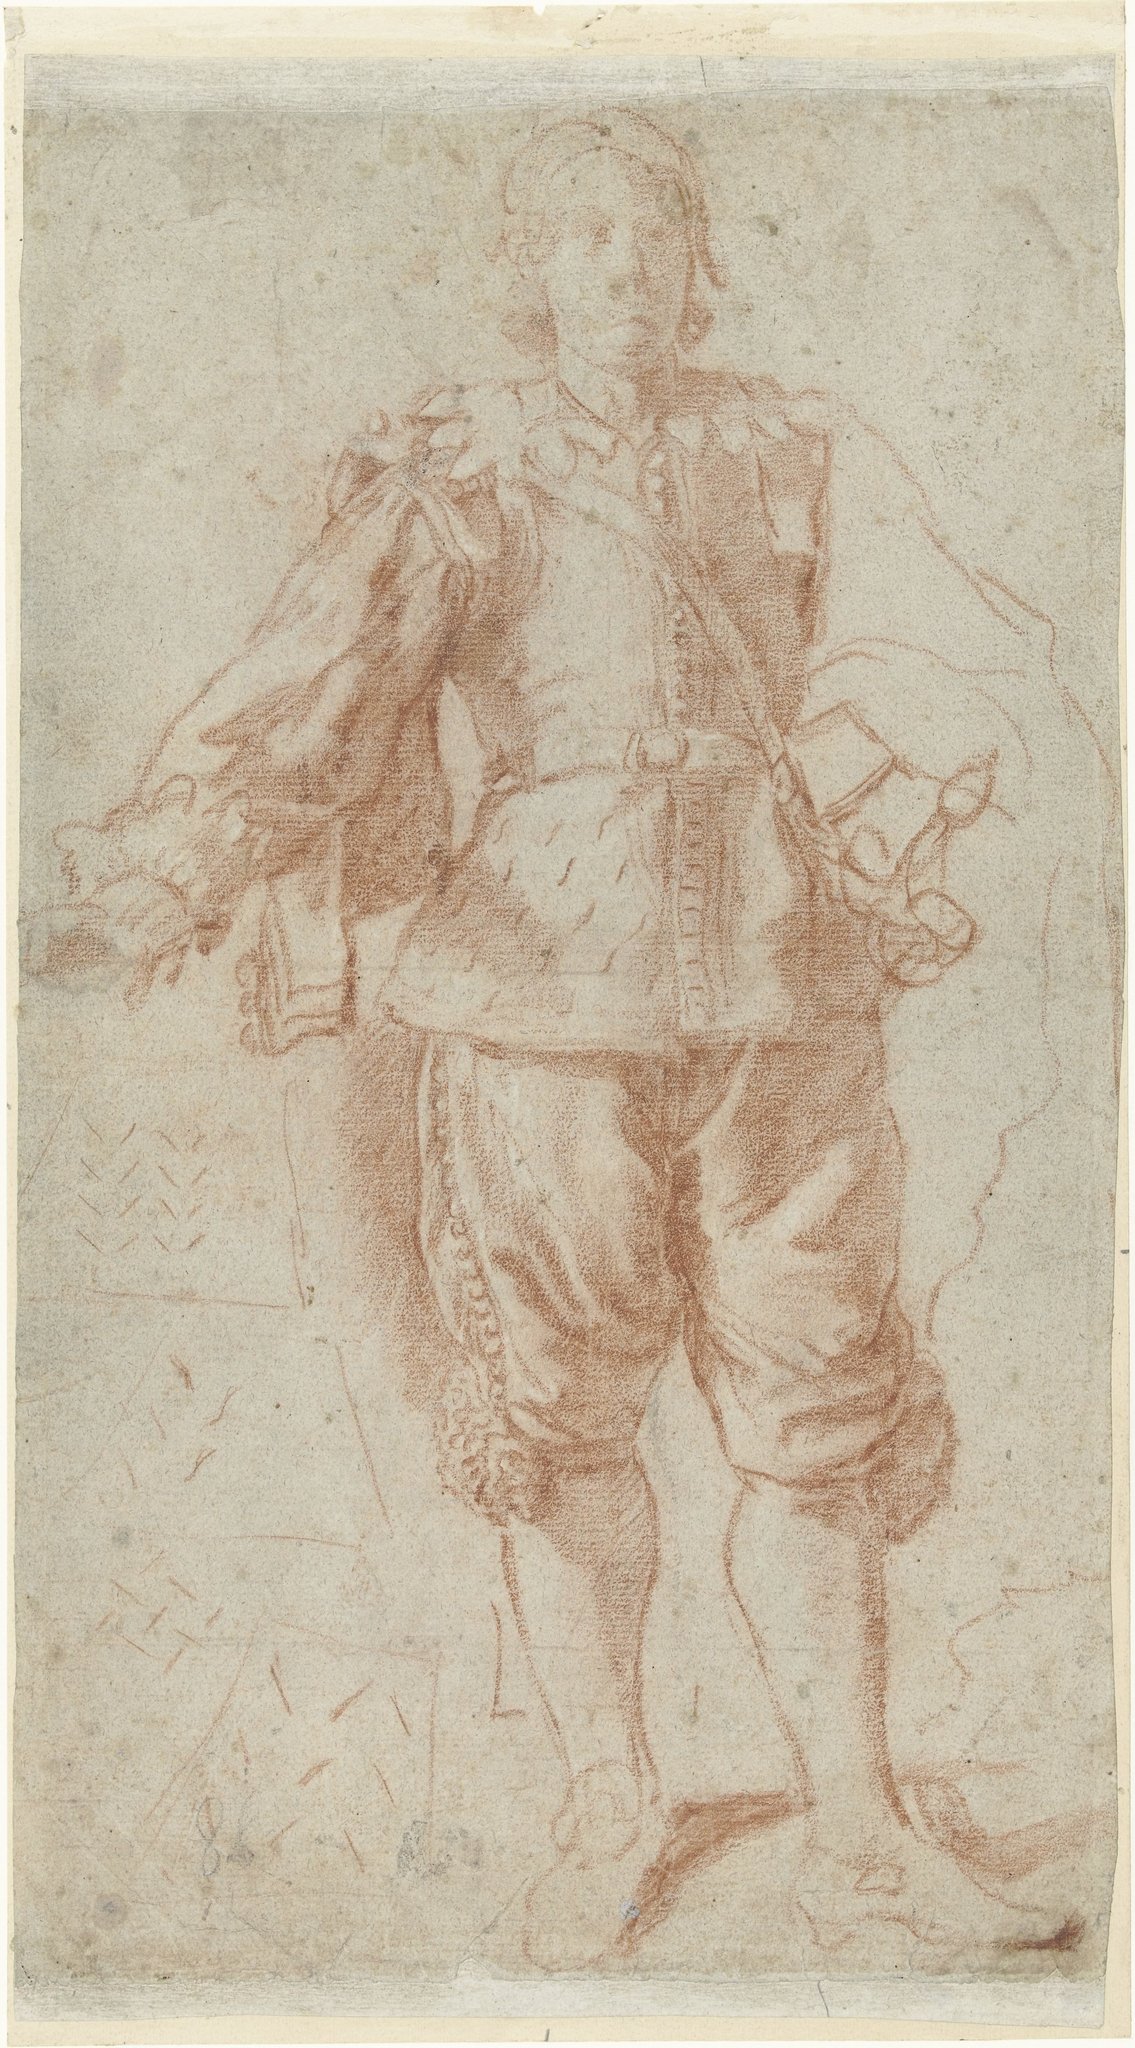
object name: drawing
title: Studie voor een portret van een jonge edelman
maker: justus sustermans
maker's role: draughtsman, painter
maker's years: 1597-1681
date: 1632-1642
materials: chalk, paper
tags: standing figure, historical persons not known by name